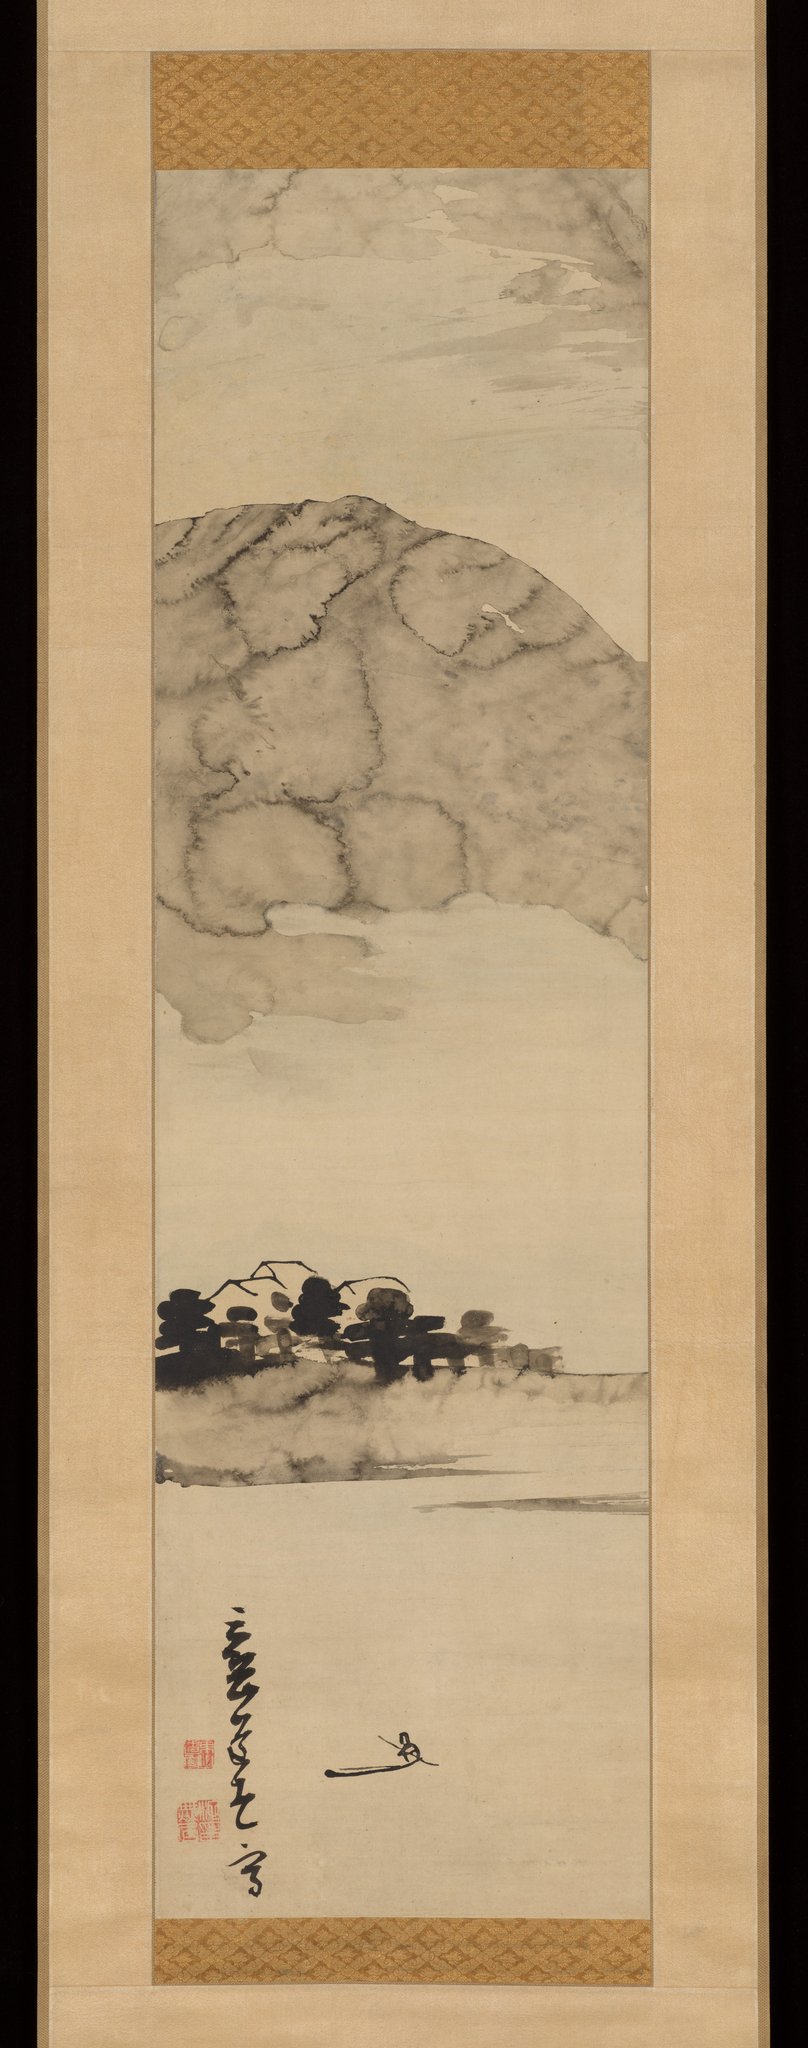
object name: hanging scroll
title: Finger Painting of a Landscape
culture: japanese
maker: ike no taiga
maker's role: artist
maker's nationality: japanese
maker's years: 1723-1776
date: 1701-1800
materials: ink, paper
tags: landscapes